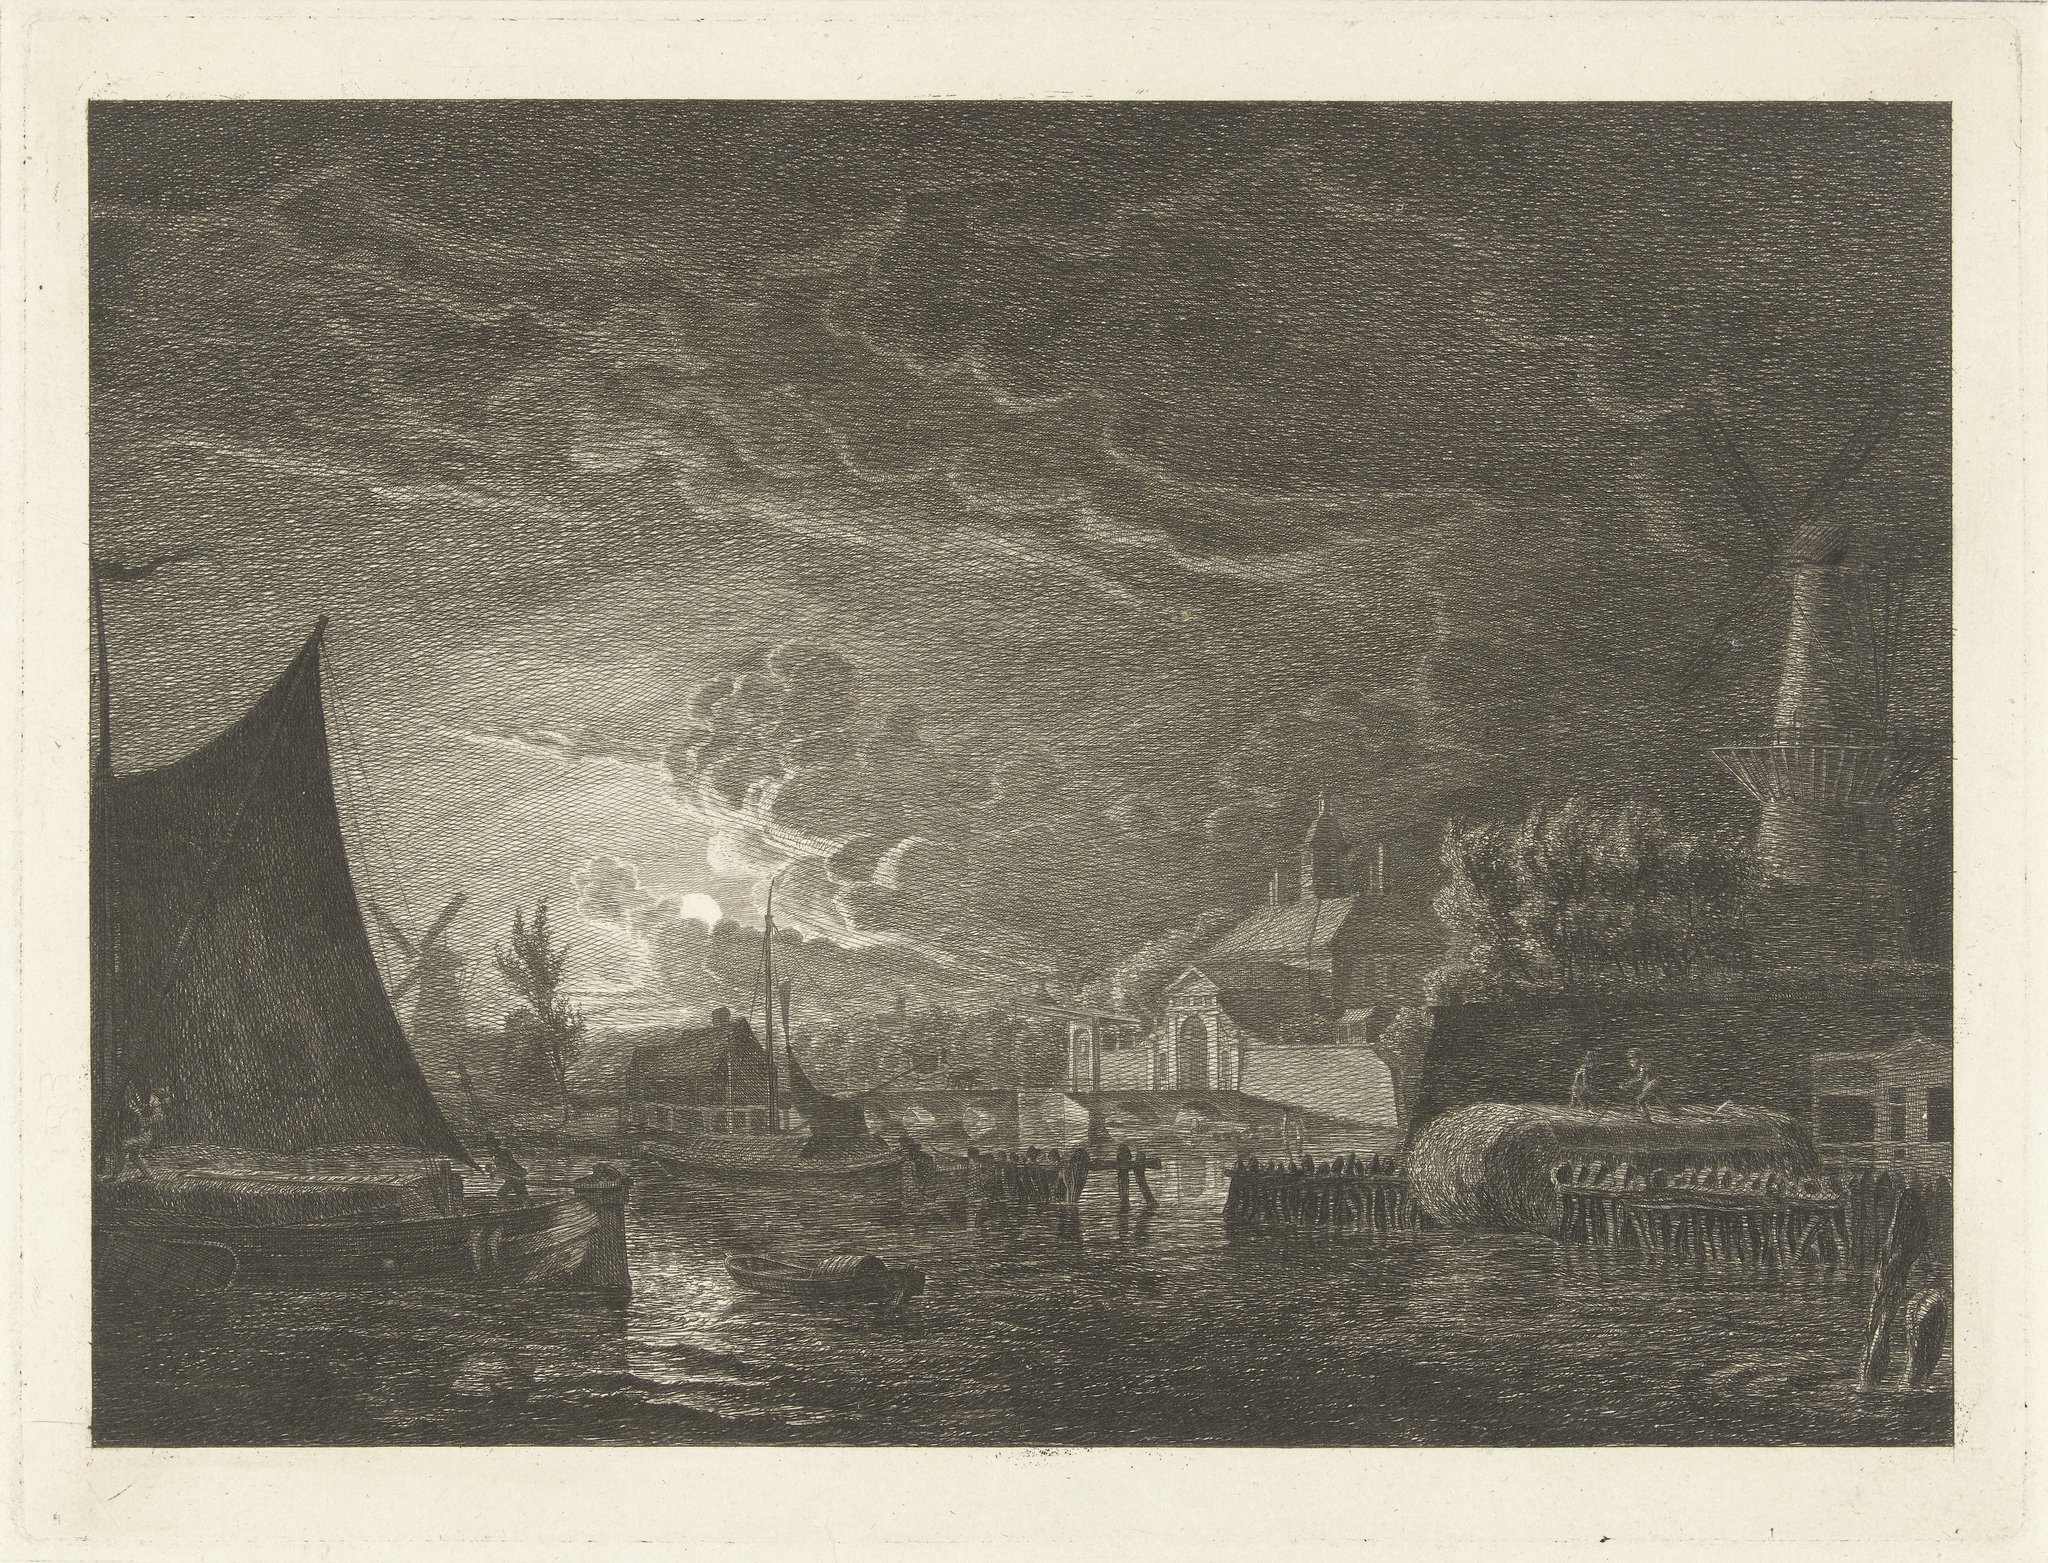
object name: print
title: Gezicht op de Marepoort te Leiden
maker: hermanus fock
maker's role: conservator, draughtsman, painter, print maker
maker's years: 1766-1822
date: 1781-1822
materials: paper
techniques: etching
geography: amsterdam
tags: leiden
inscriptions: collector's mark: Lugt 2228, name: ‘H: Fock’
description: De Marepoort met ophaalbrug te Leiden onder donkere wolken, gezien vanaf het water (het Singel?). Op de voorgrond links een met hooi geladen zeilschuit. Rechts een molen en twee mannen op een schuit met hooi bij de stadswal.